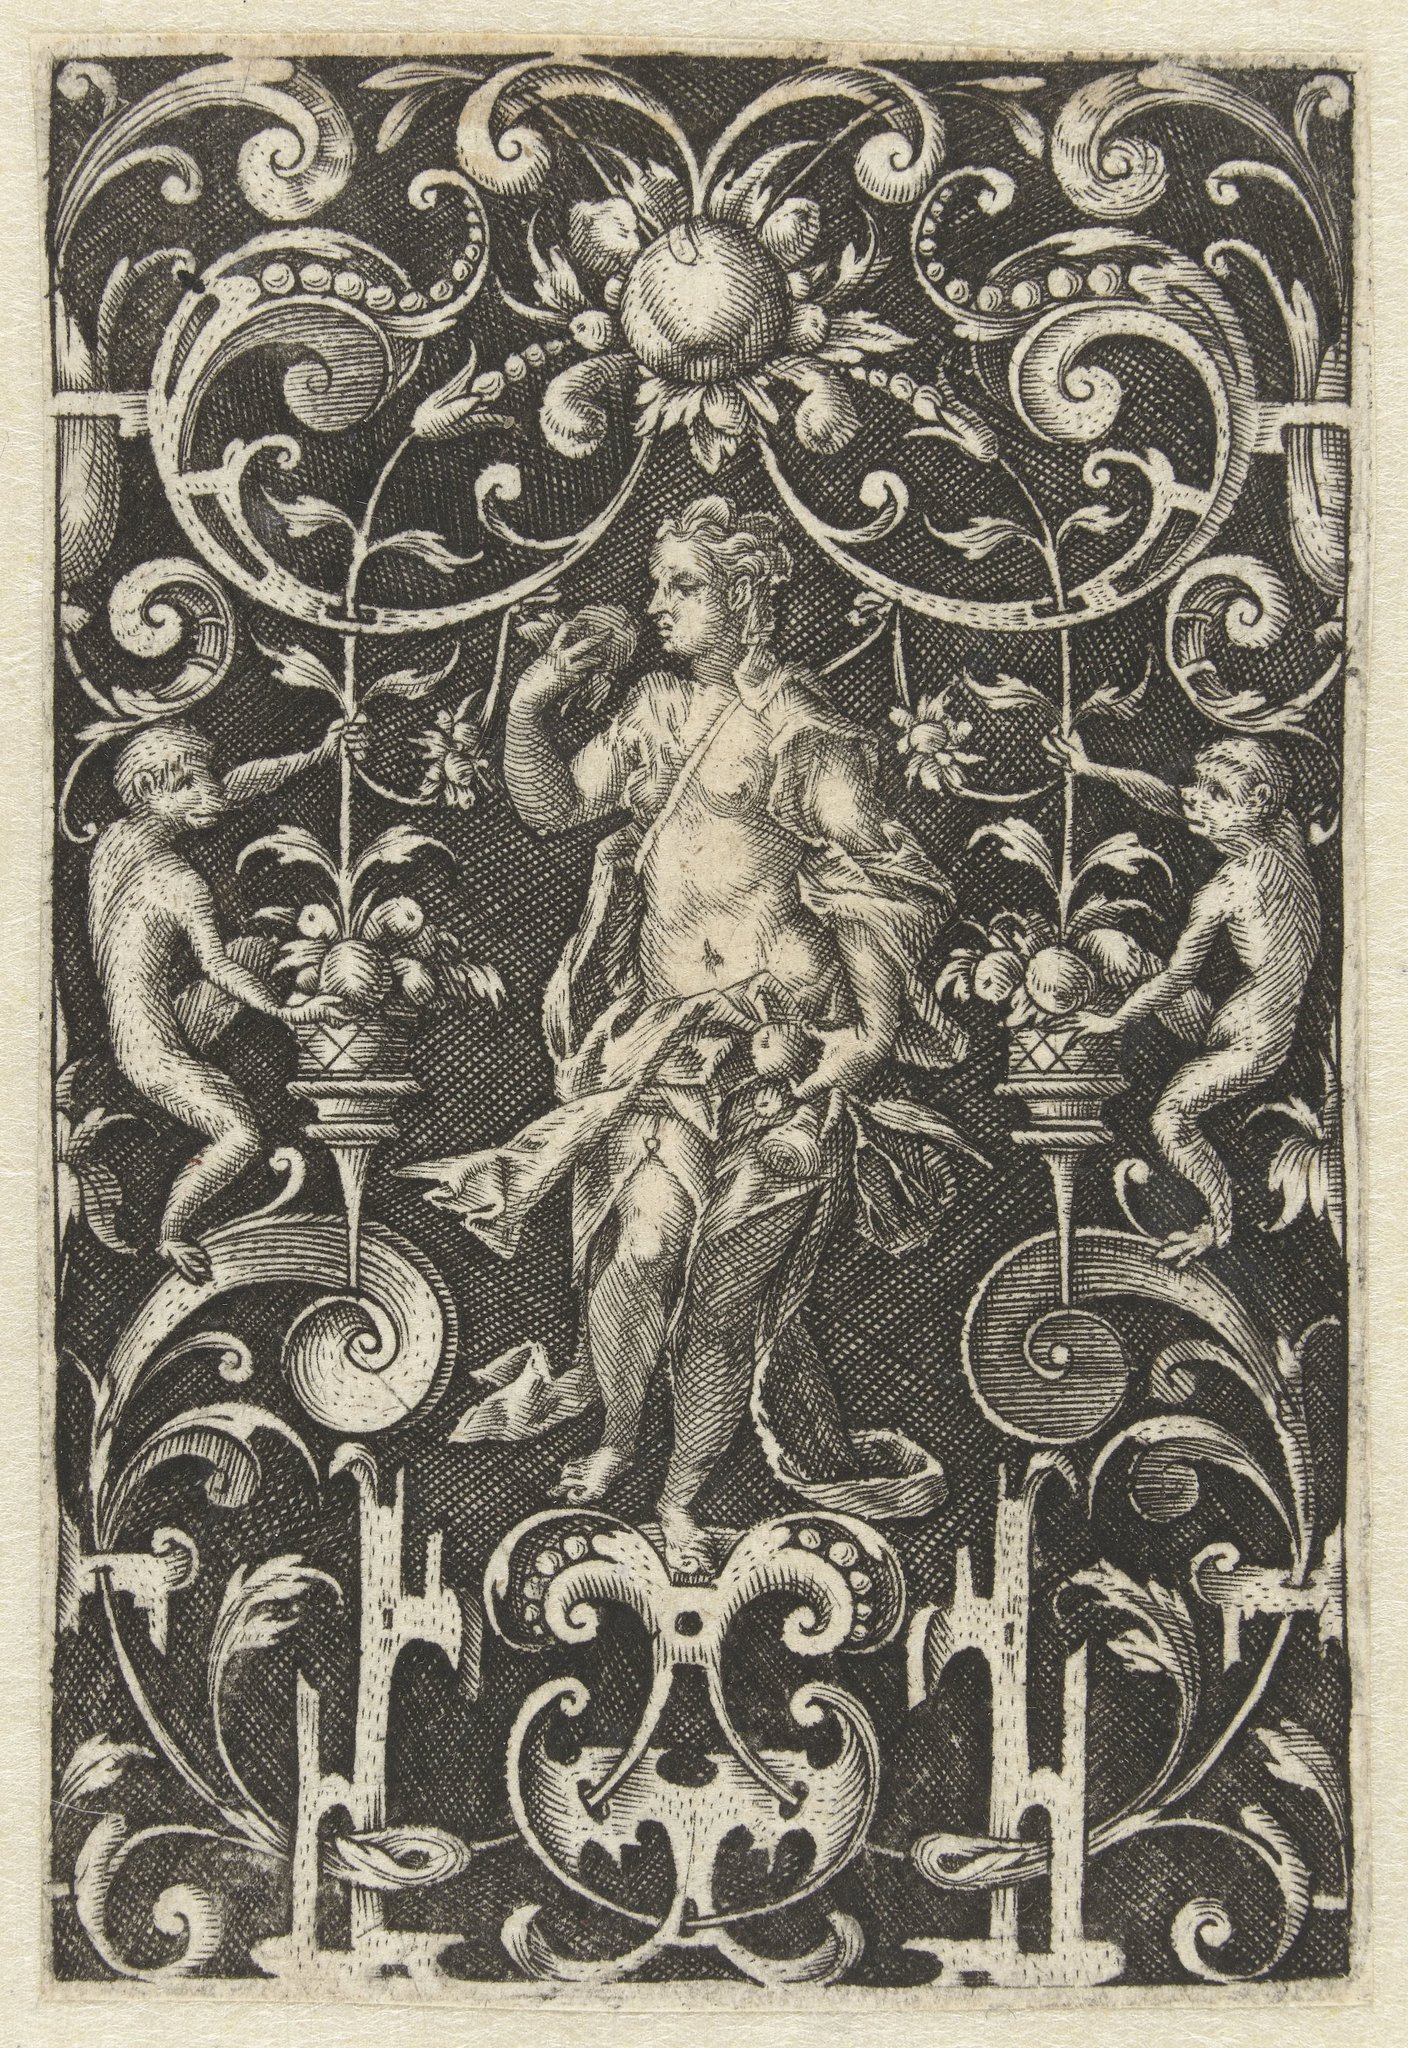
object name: ornament print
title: Vlakdecoratie met de Smaak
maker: Anonymous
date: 1563-1633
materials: paper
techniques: engraving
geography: germany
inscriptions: collector's mark: Lugt 1379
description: Een vrouw met vruchten tussen twee apen. Gearceerde achtergrond. Uit serie bestaande uit een titelblad en 5 bladen met vlakdecoraties.